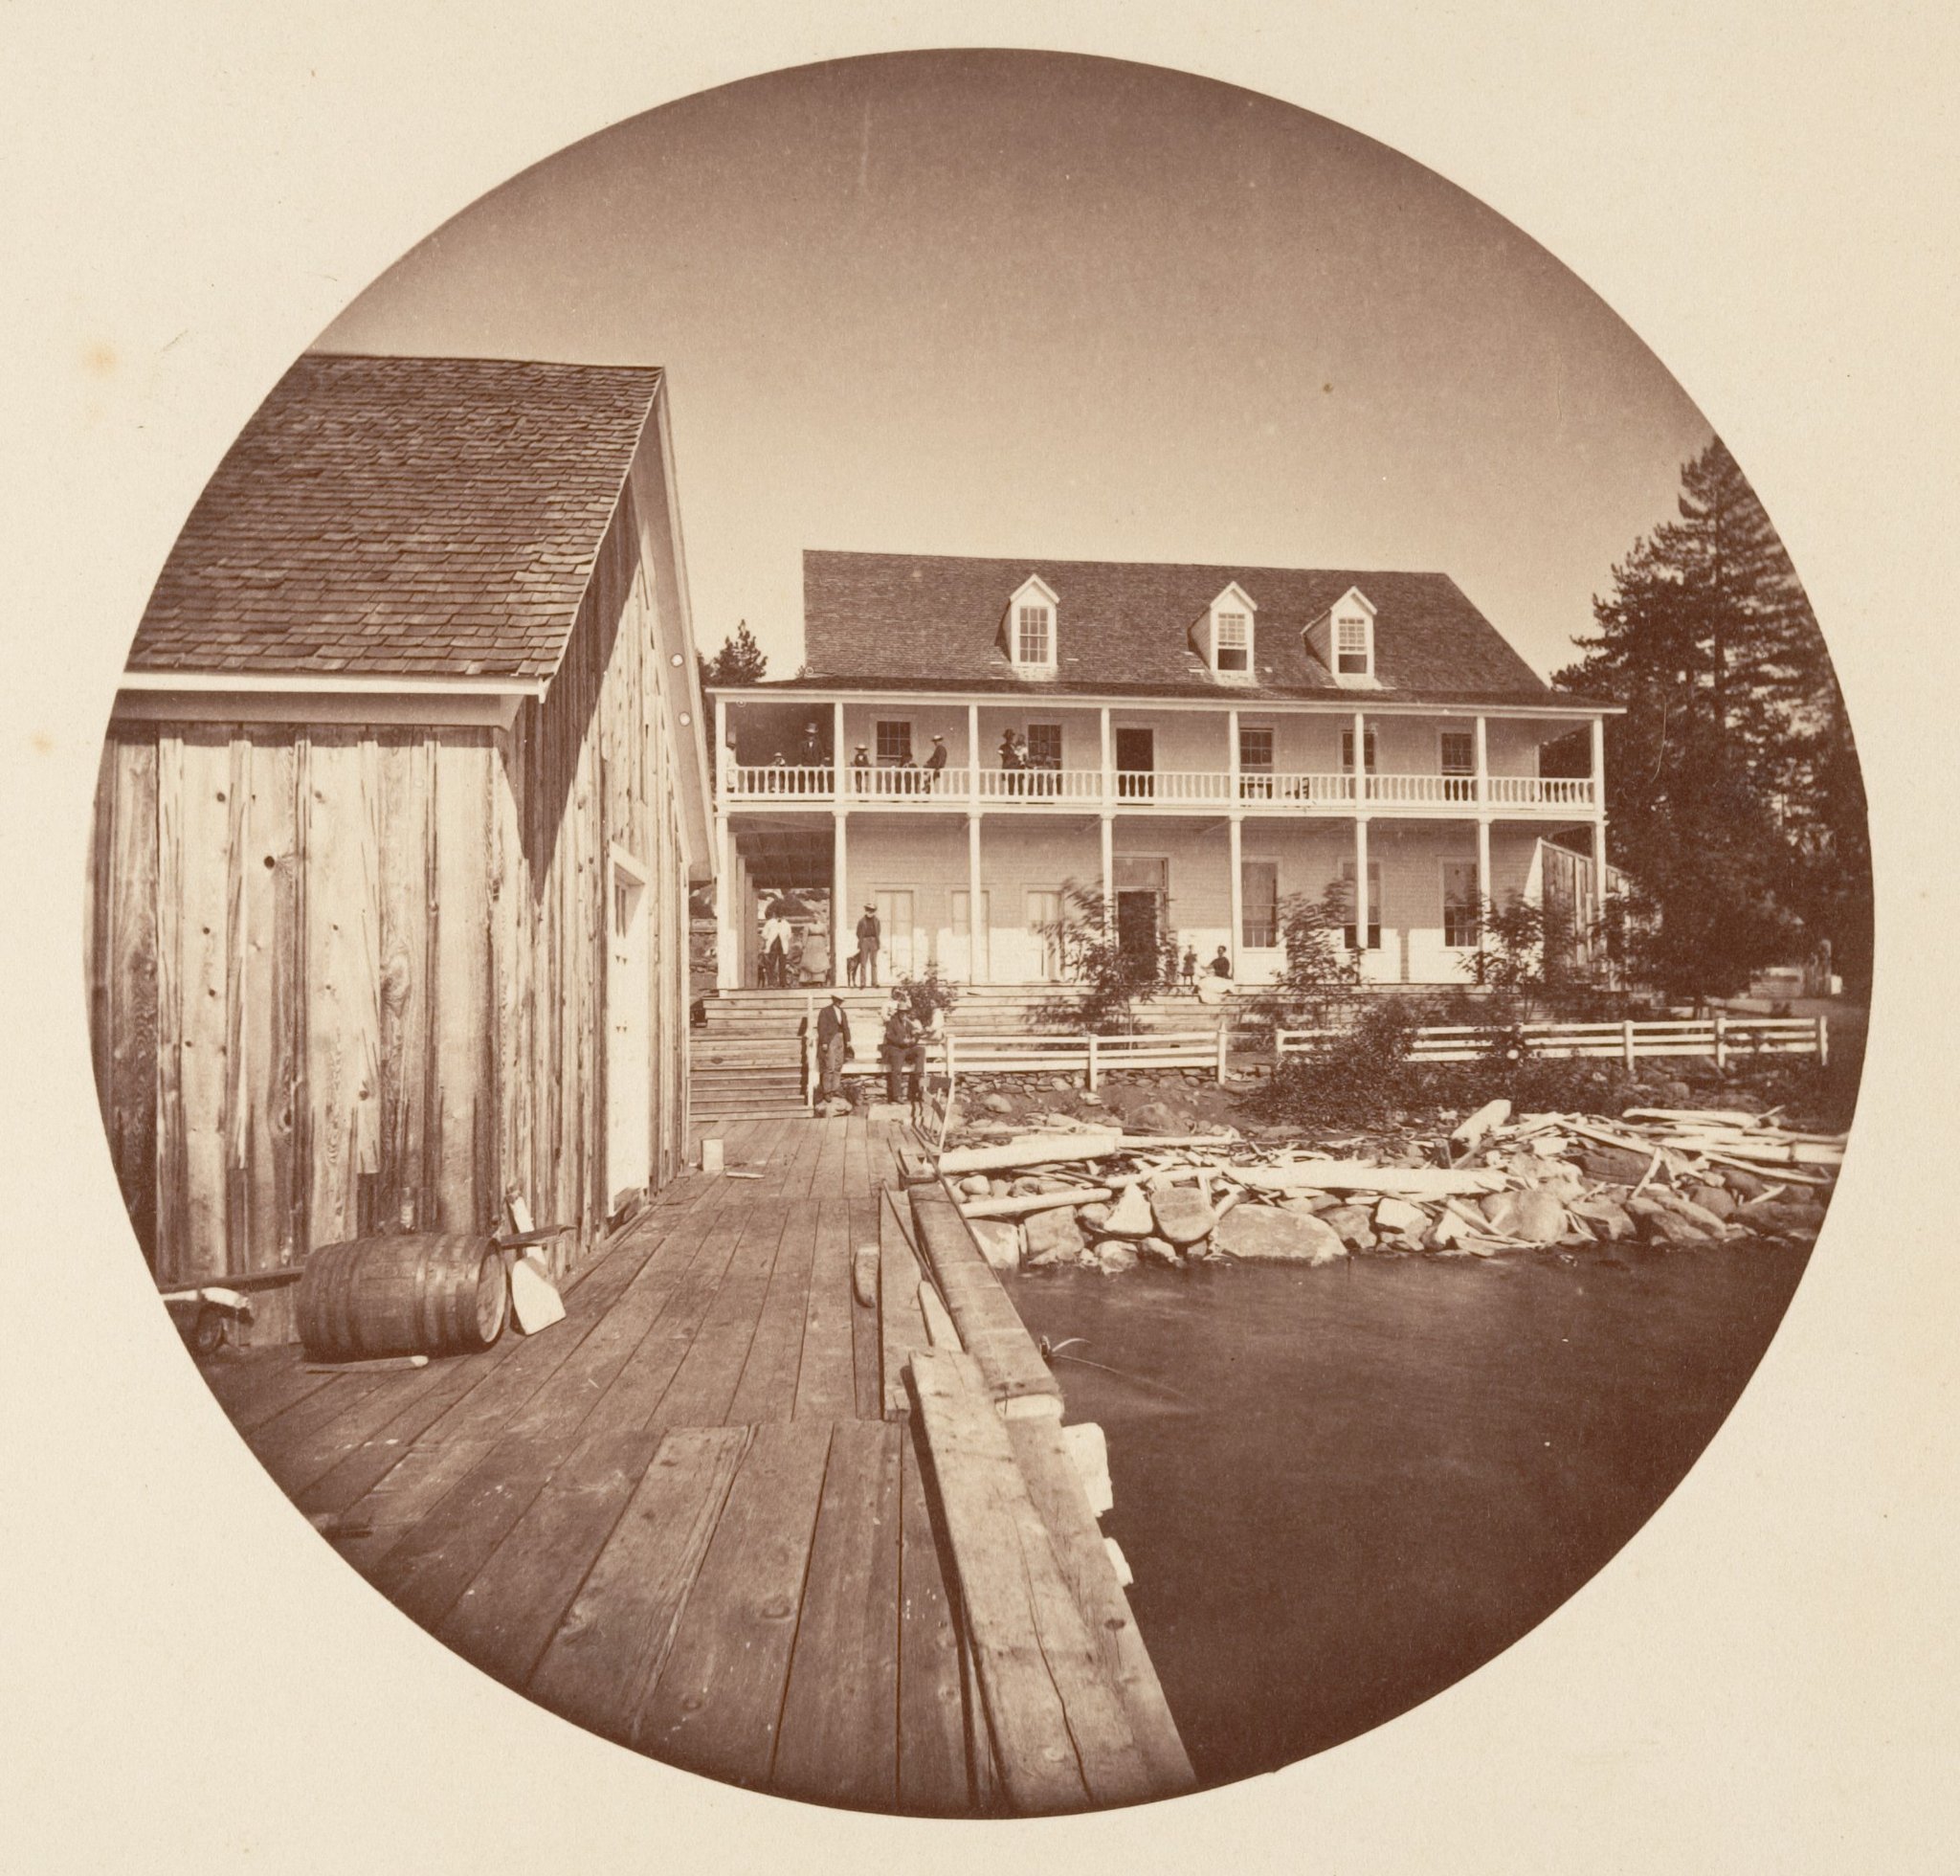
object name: photograph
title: Warm Springs Hotel Lake Tahoe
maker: carleton e. watkins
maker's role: artist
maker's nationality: american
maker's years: 1829-1916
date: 1878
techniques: albumen silver print, glass negative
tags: buildings,hotels